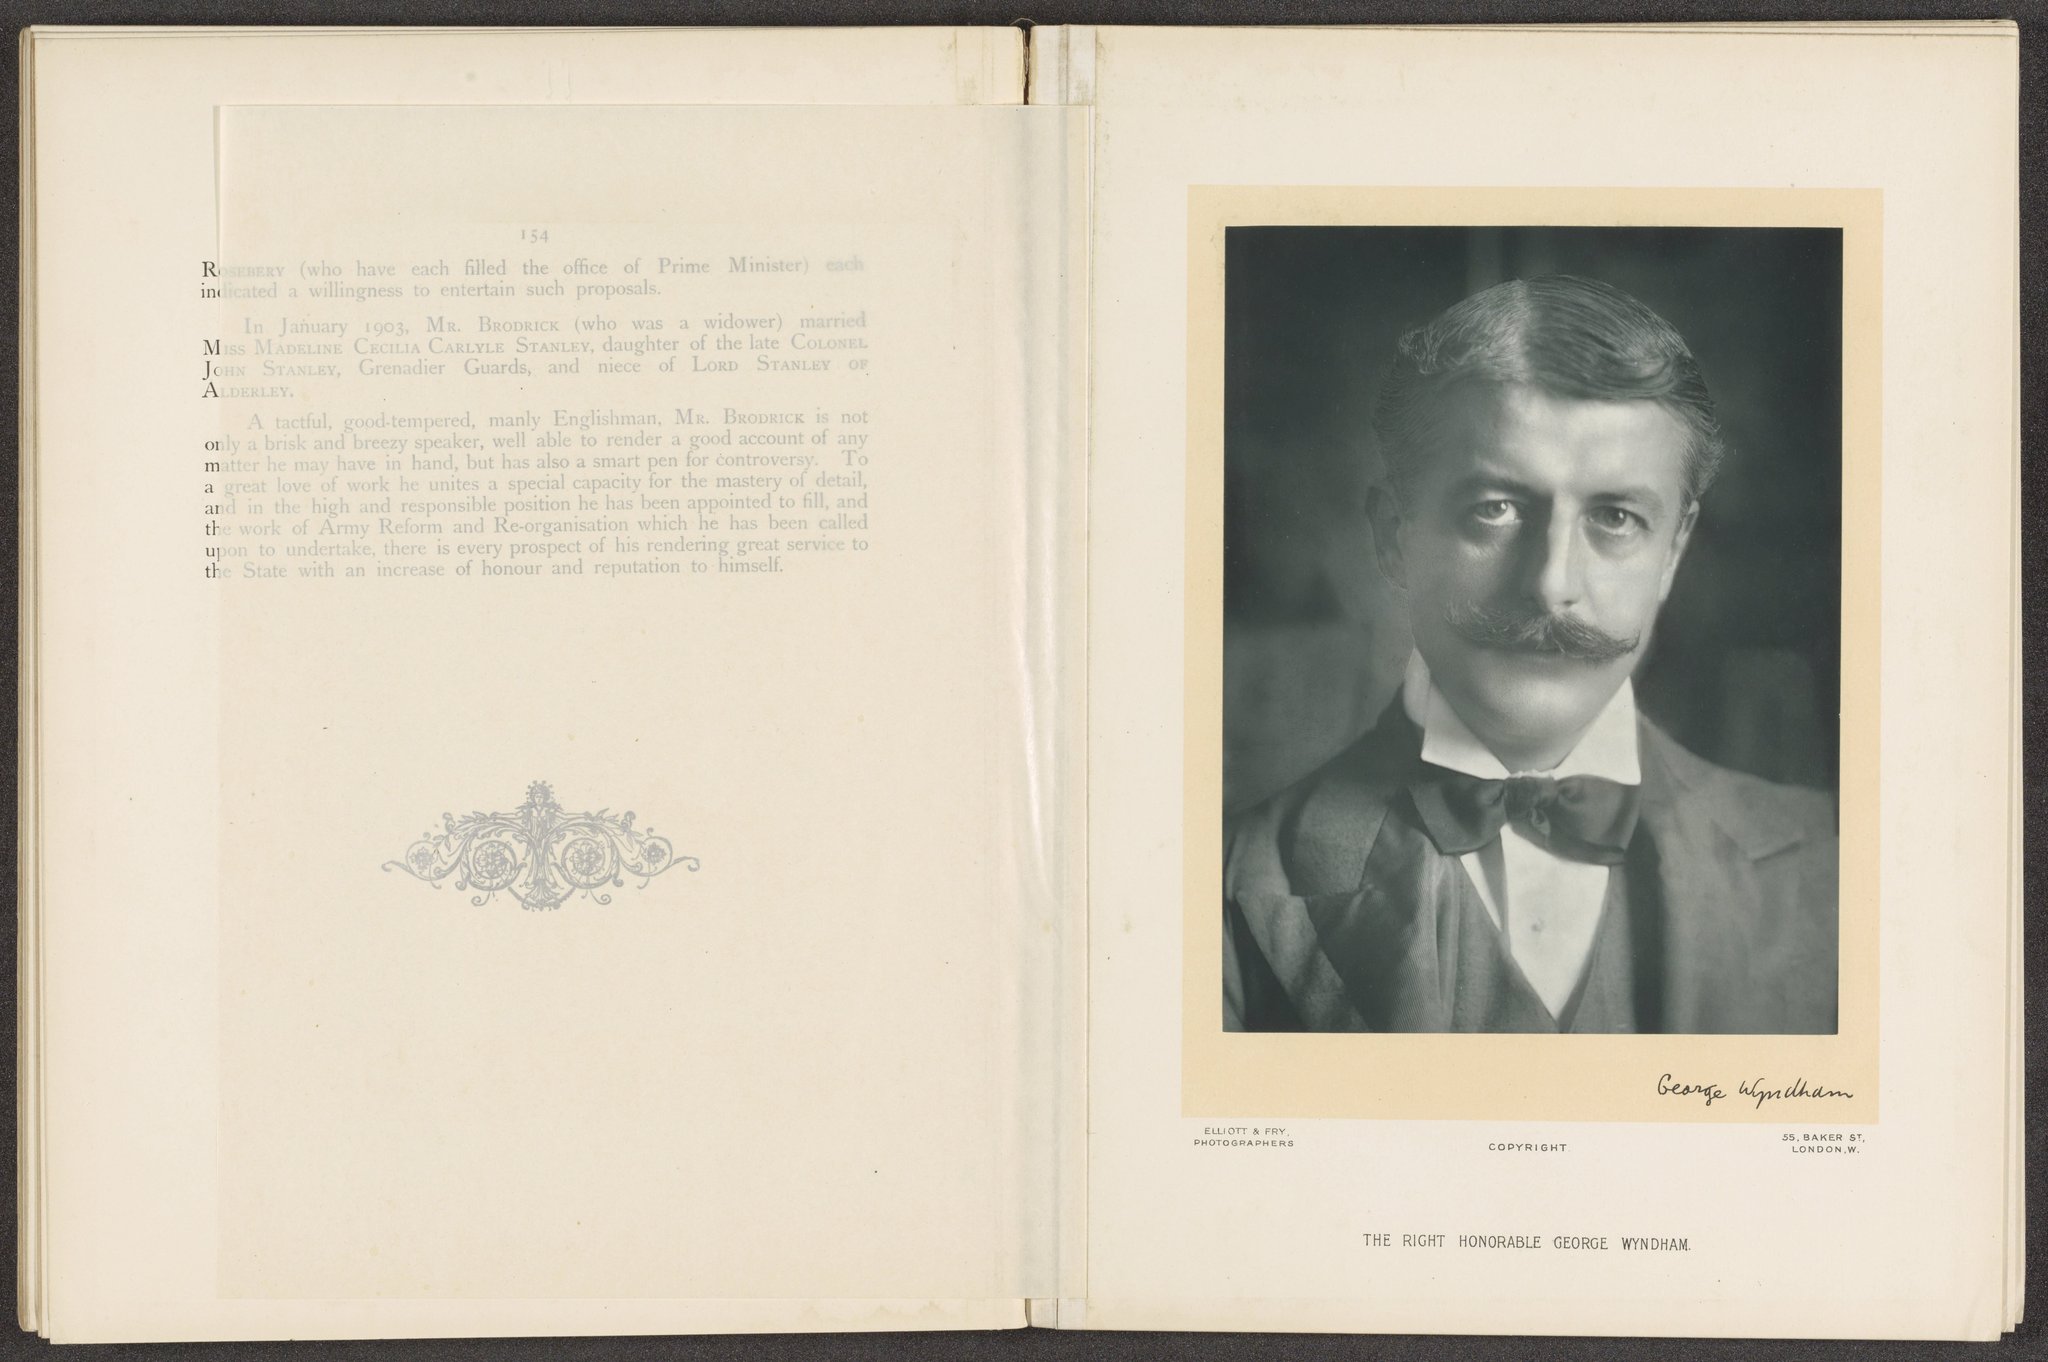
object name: page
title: The right honorable George Wyndham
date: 1893-1903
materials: paper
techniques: carbon print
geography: london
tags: politician, george wyndham (4e hertog van egremont), historical persons (portraits and scenes from the life) (+ (full) bust portrait)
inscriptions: inscription: ‘55, Baker St, London, W.’, annotation